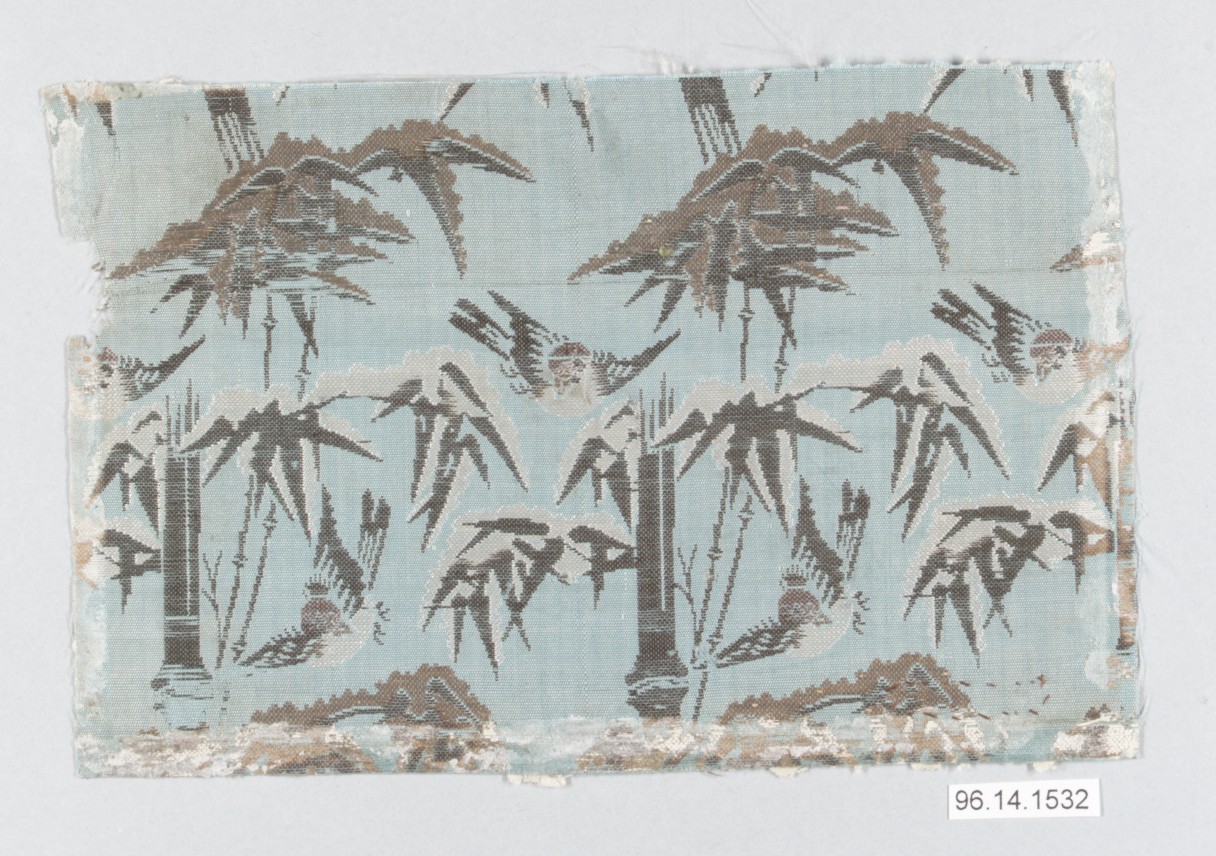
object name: piece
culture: japanese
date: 1701-1900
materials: silk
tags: birds,bamboo